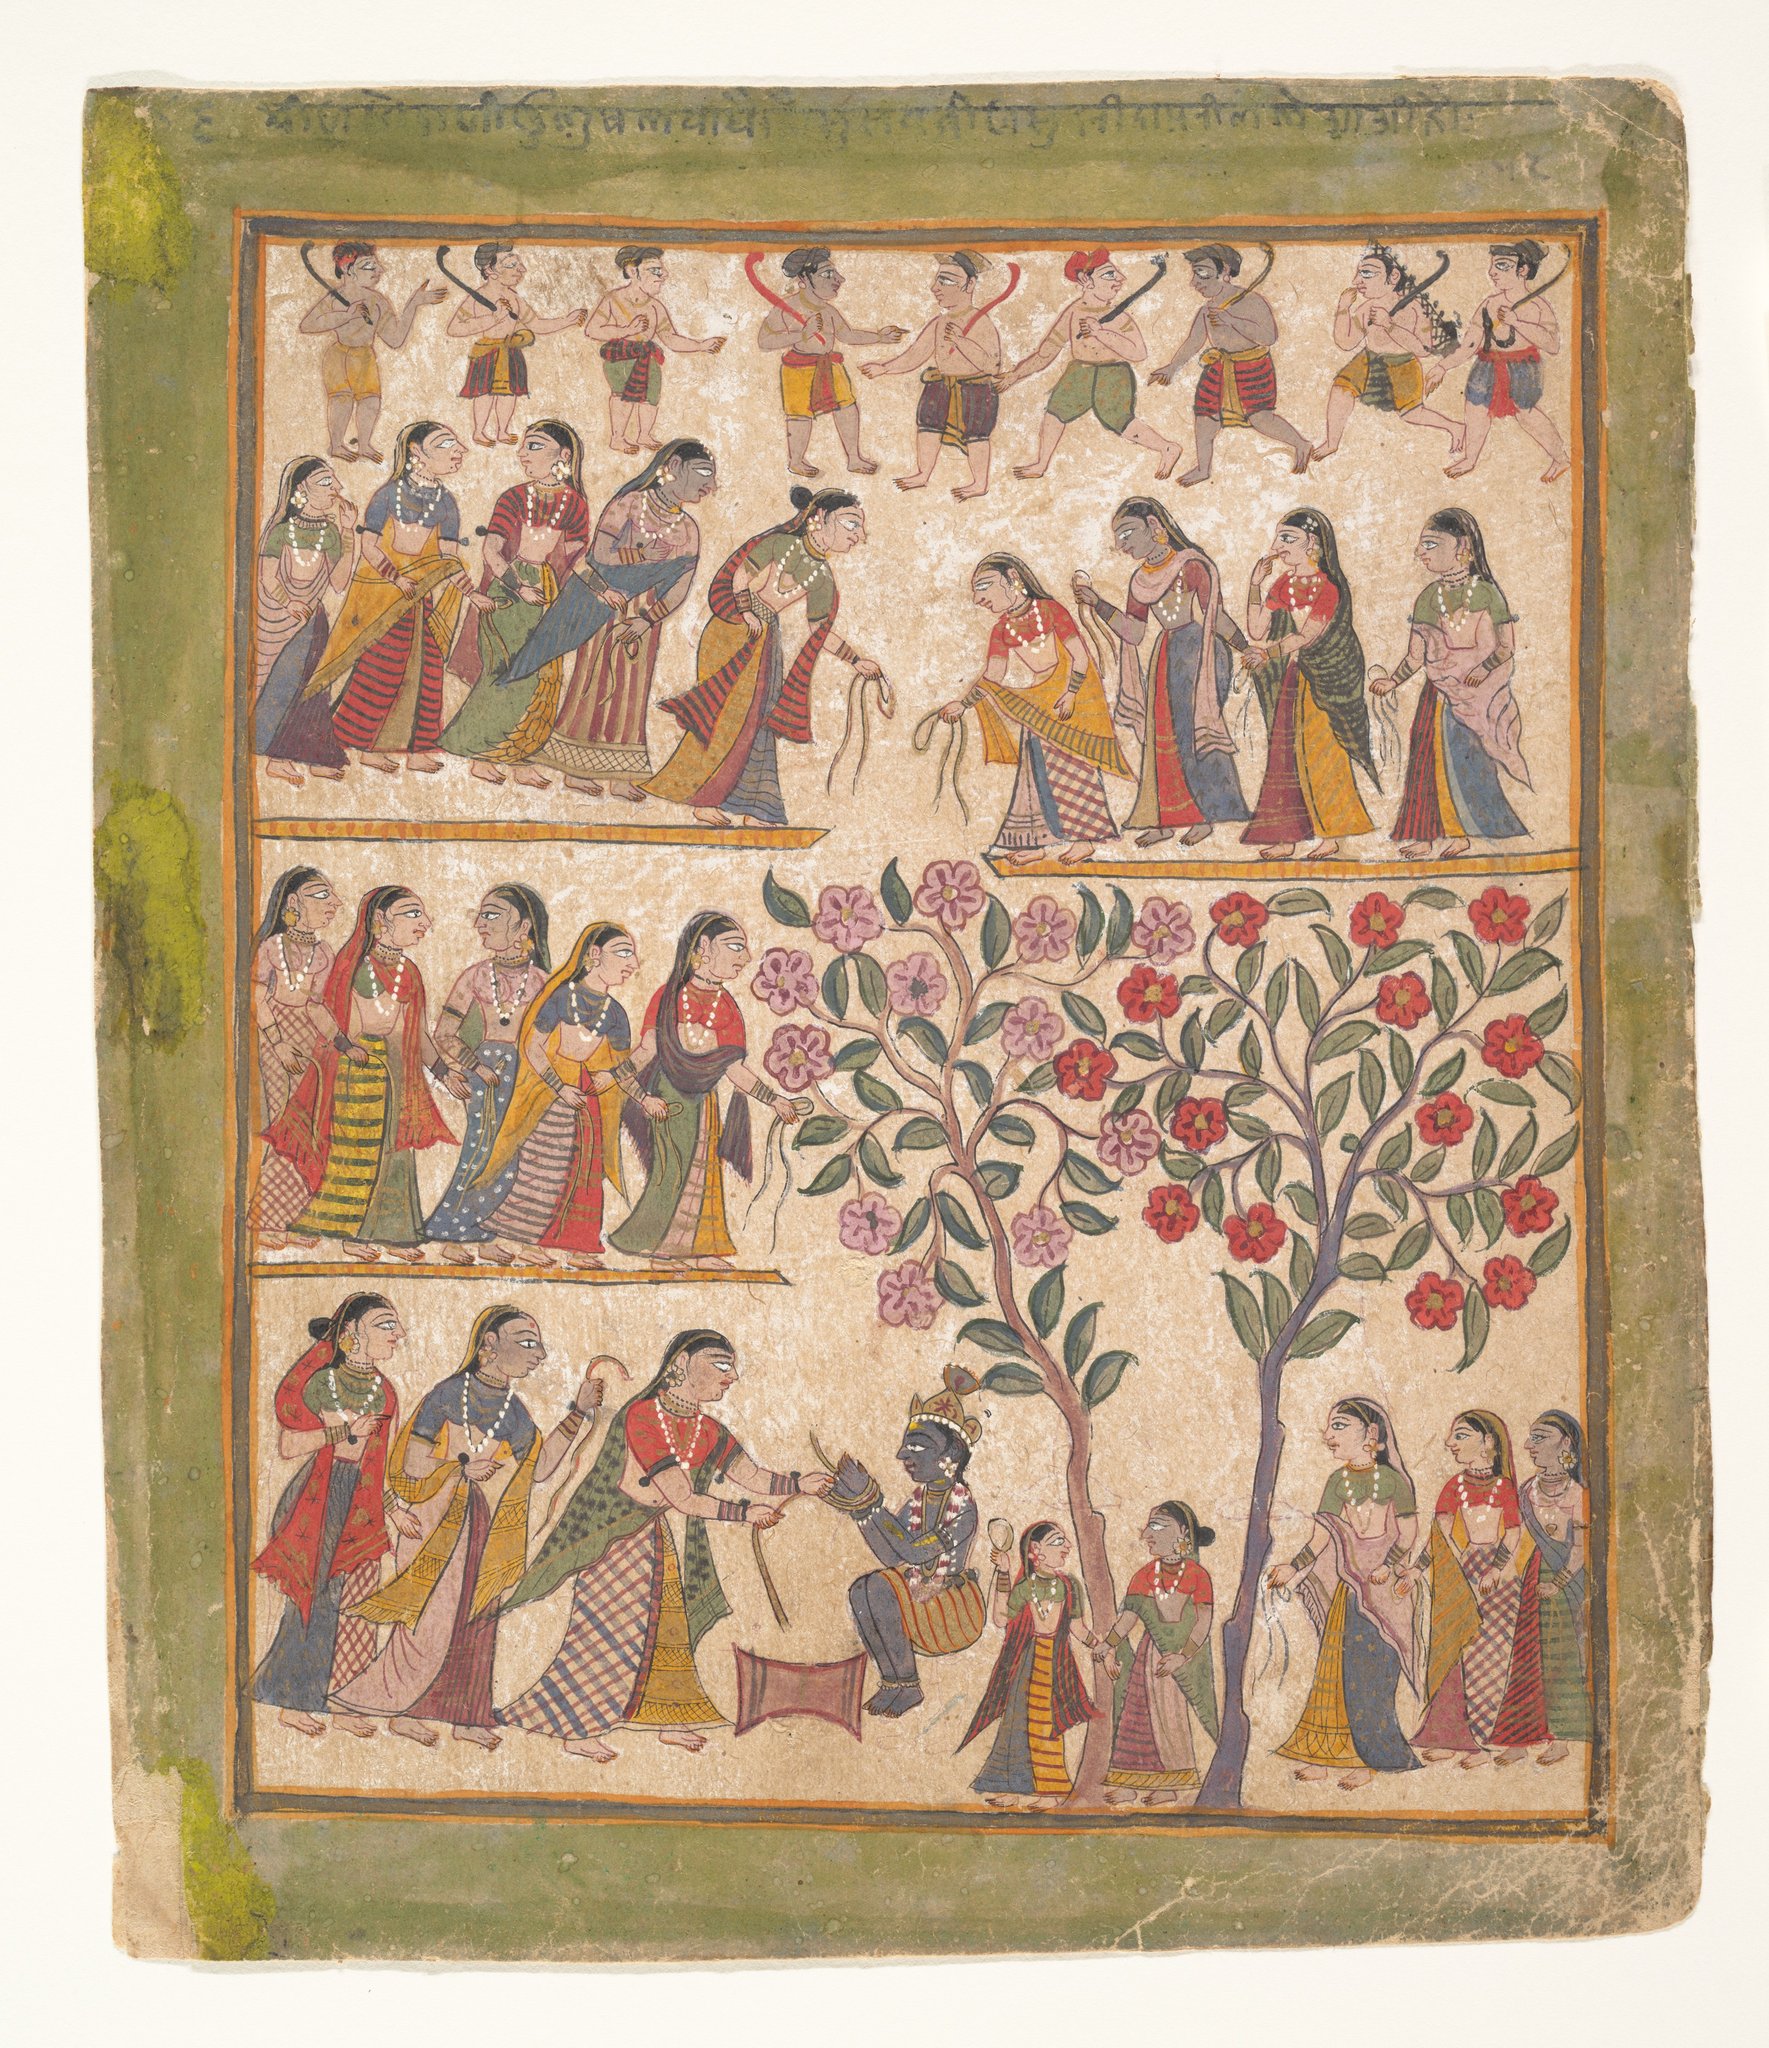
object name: folio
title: Yashoda Binds Krishna’s Hands: Page from a Dispersed Bhagavata Purana Manuscript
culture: indian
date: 1640-1650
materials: ink, paper, watercolor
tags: men,women,krishna